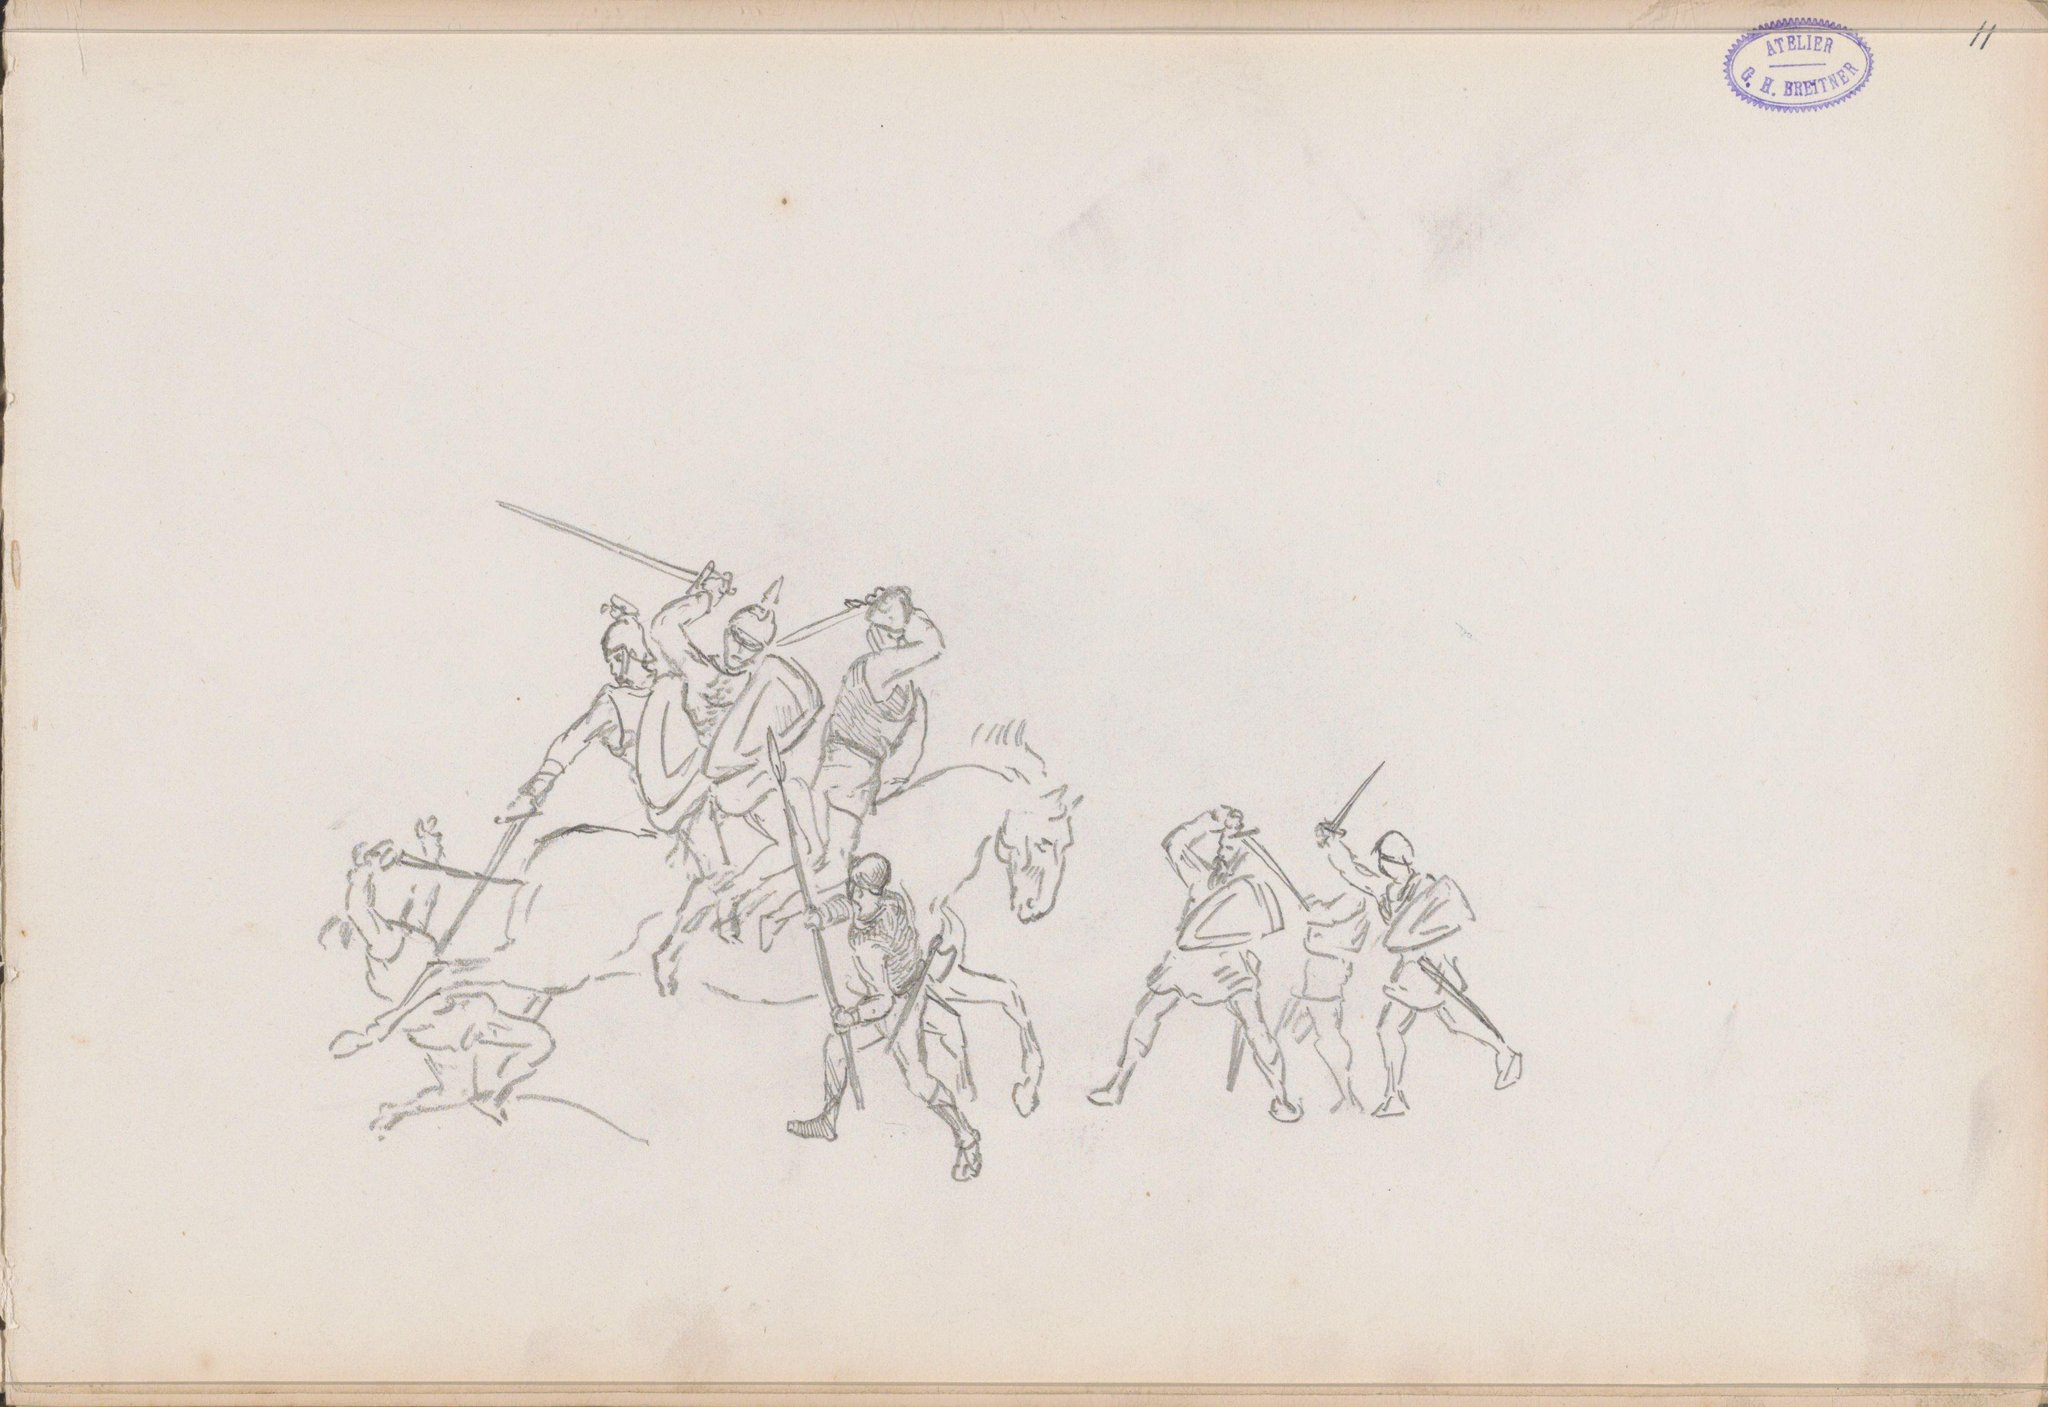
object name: sketchbook leaf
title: Strijdende soldaten, deels te paard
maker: george hendrik breitner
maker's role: draughtsman, painter, print maker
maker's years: 1857-1923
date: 1809-1872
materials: paper, pencil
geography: rotterdam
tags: division of armed forces (+ during the battle), division of armed forces (+ cavalry, horsemen)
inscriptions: workshop stamp: Lugt 291d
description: Blad 11 uit een schetsboek met 32 bladen.